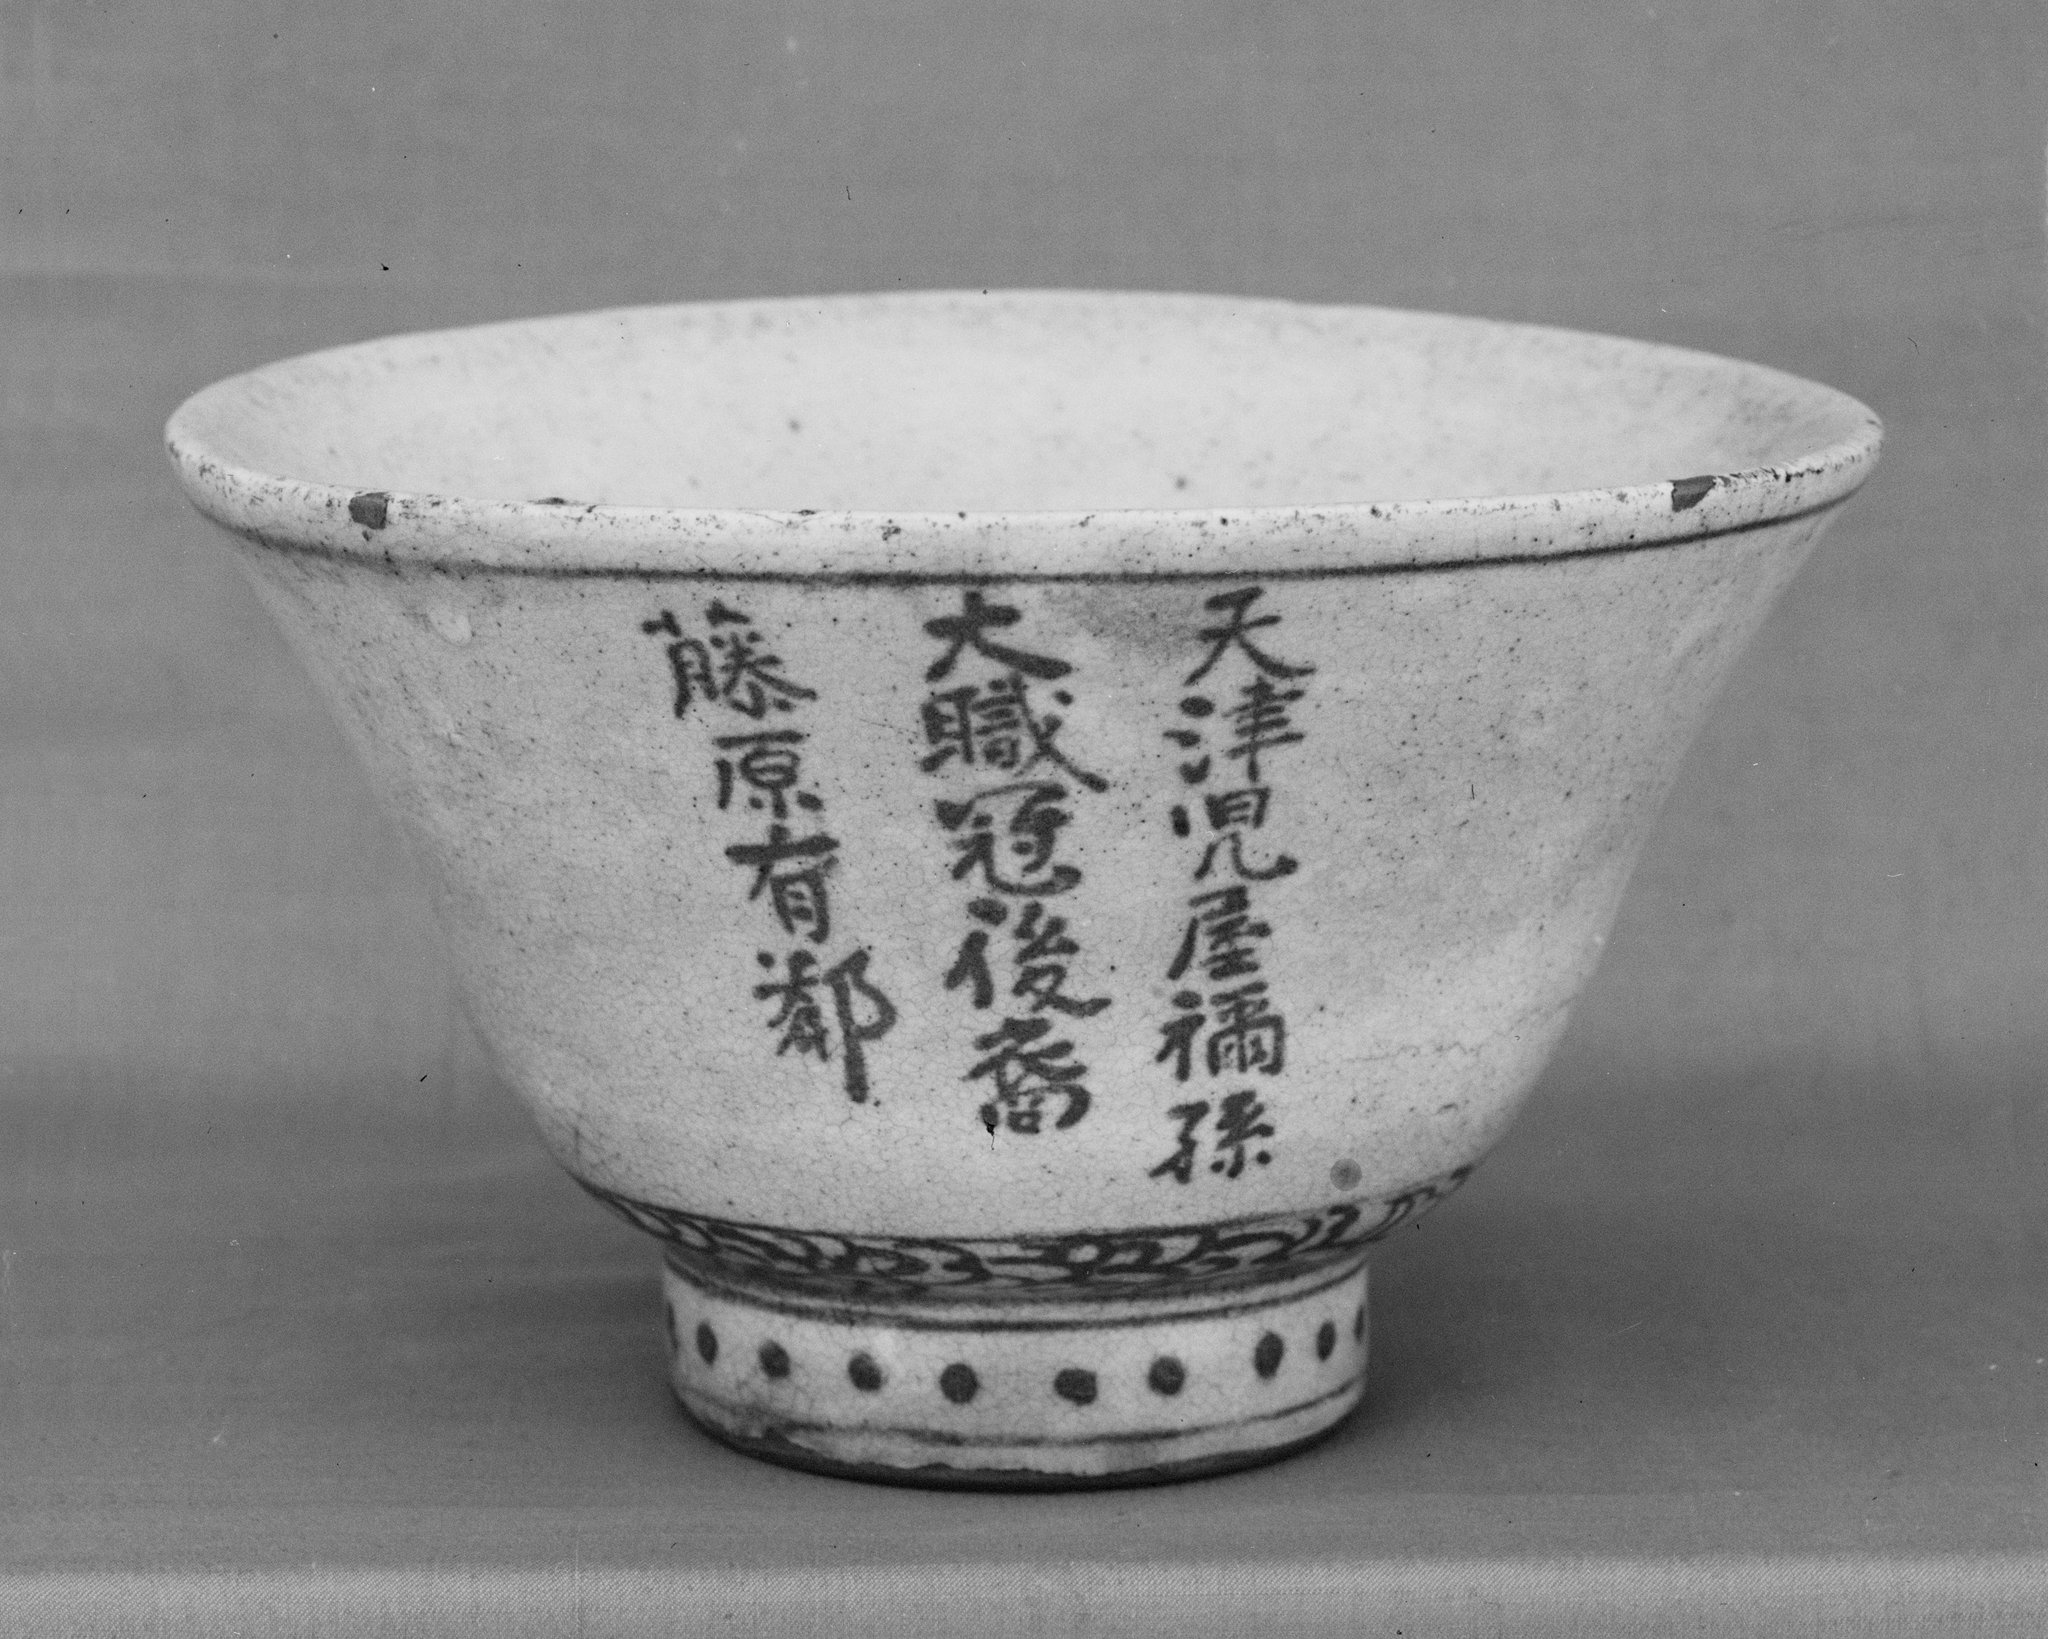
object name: cup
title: Deep Cup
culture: japanese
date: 1801-1900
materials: clay, glaze